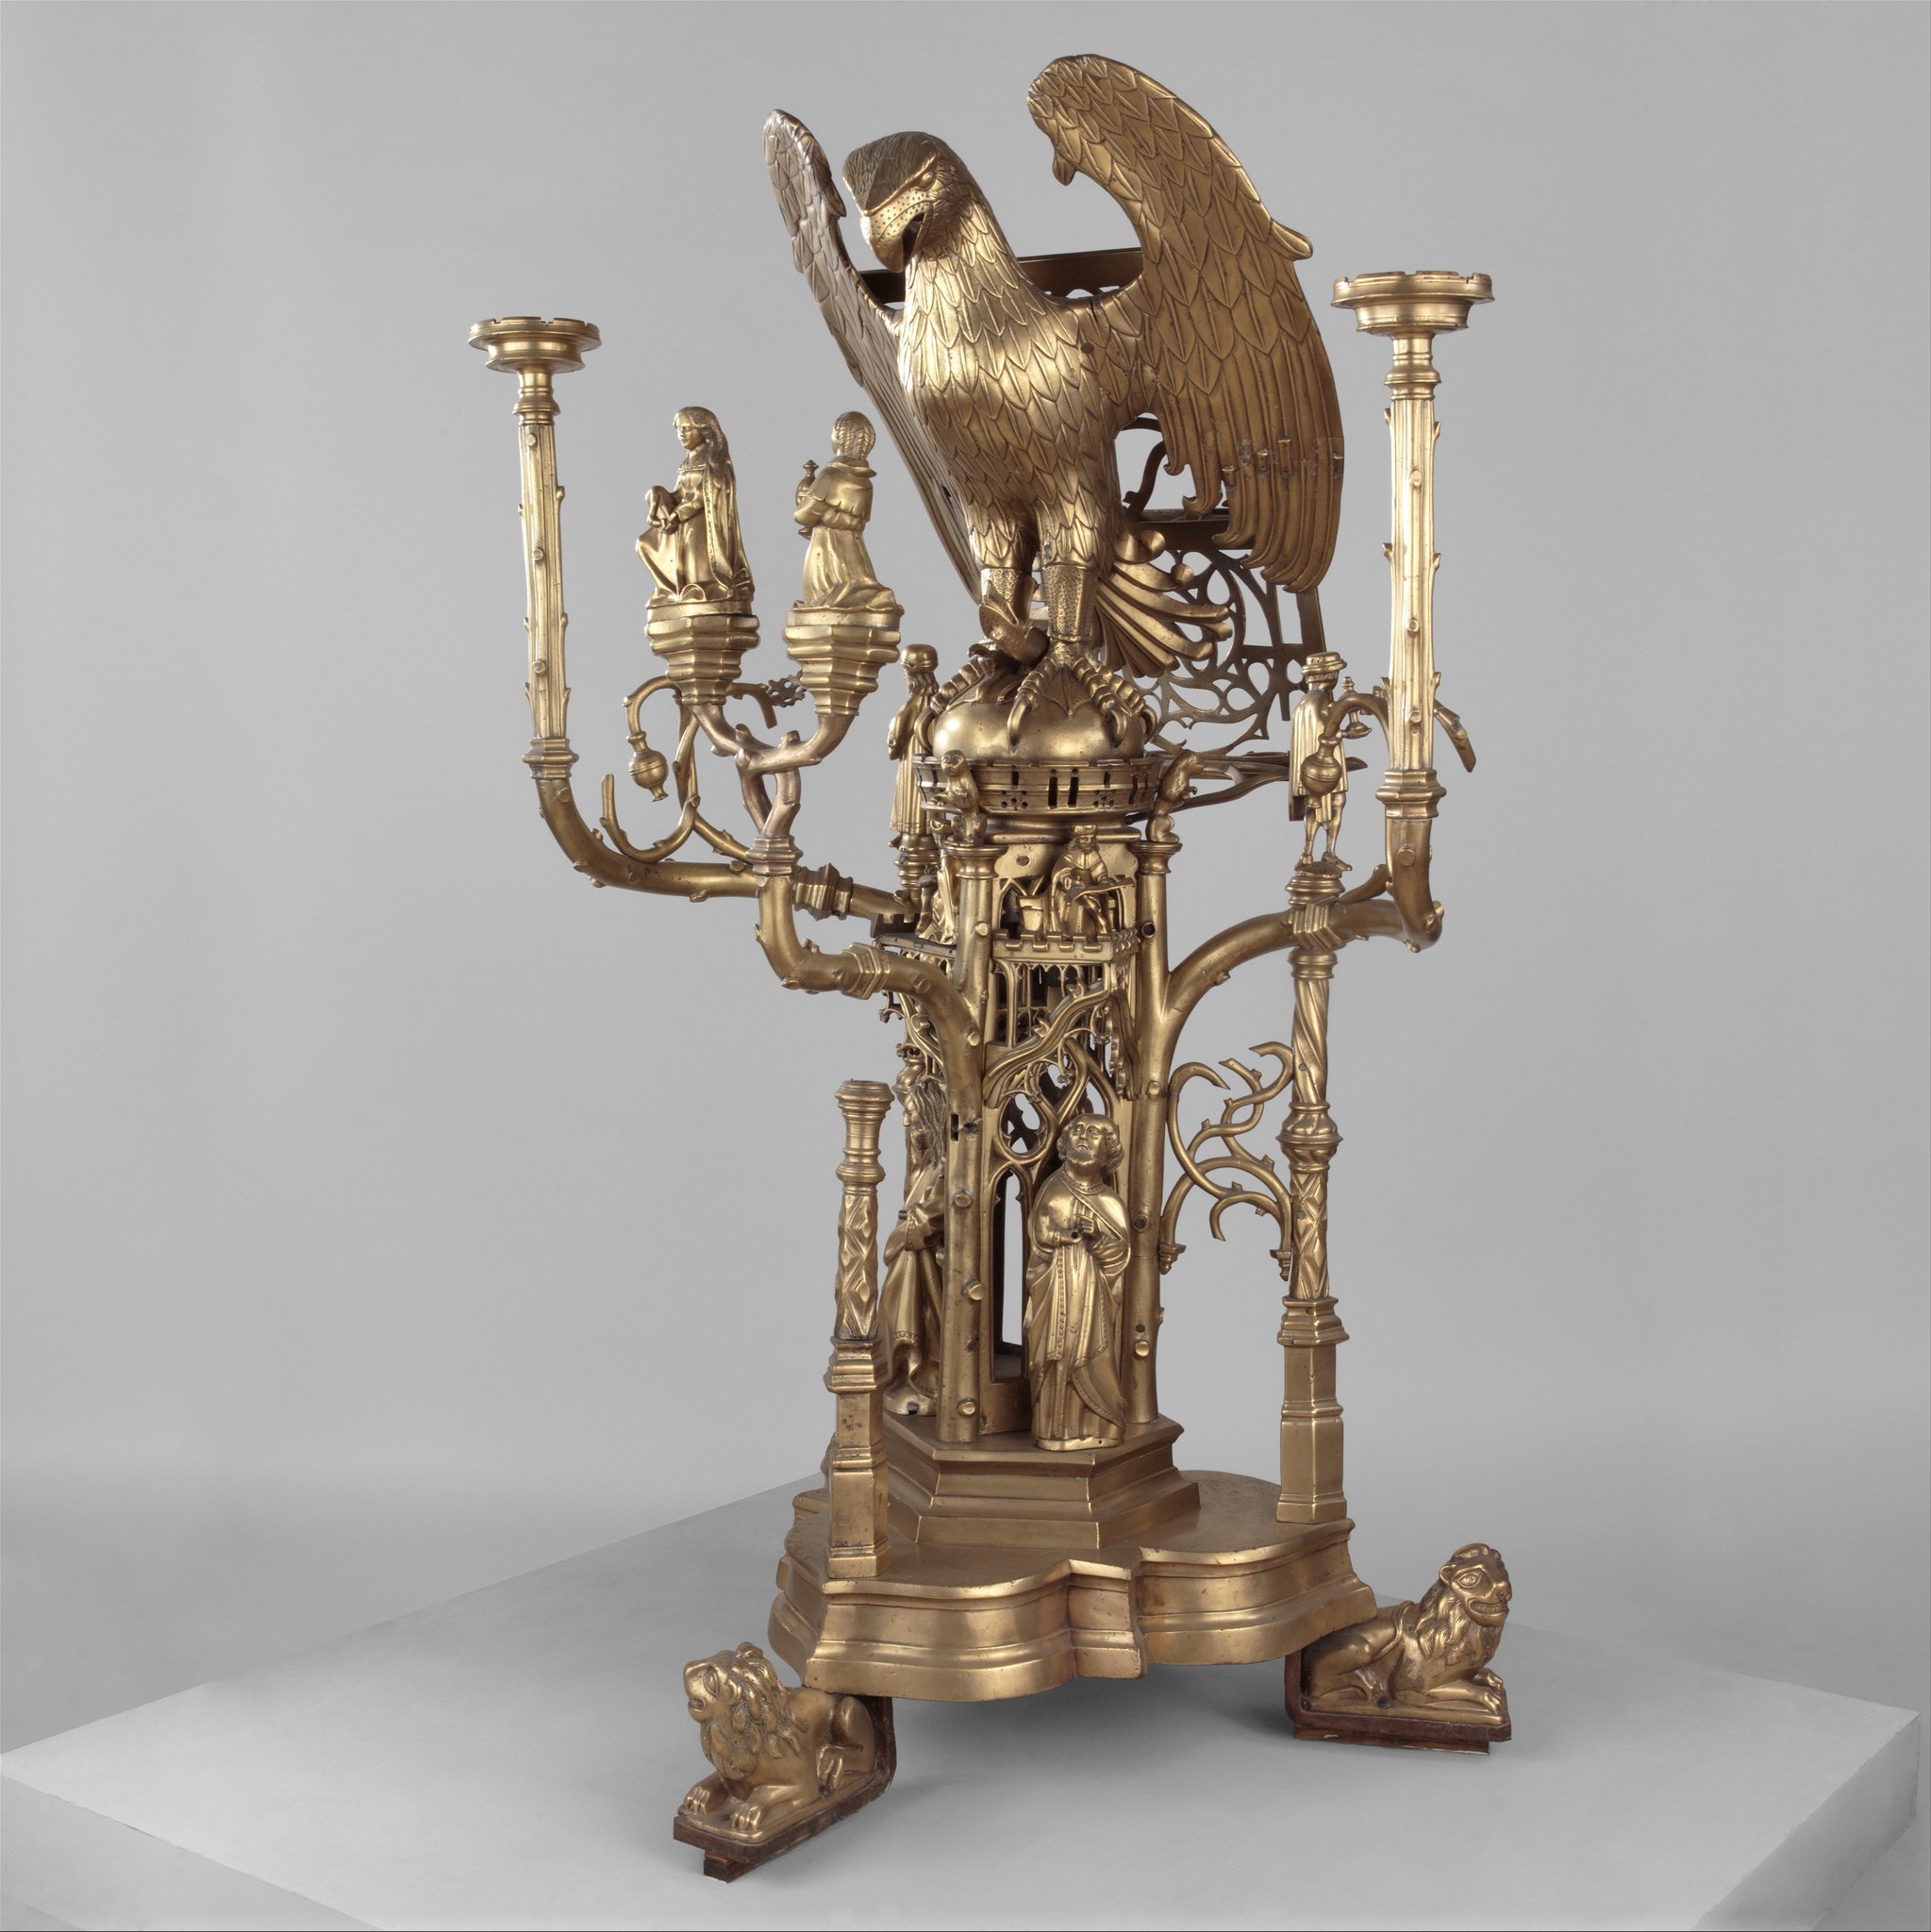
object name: lectern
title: Lectern in the Form of an Eagle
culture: south netherlandish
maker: jehan aert van tricht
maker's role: artist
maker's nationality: netherlandish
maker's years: 1492-1501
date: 1500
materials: brass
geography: netherlands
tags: eagles,lions,adoration of the magi